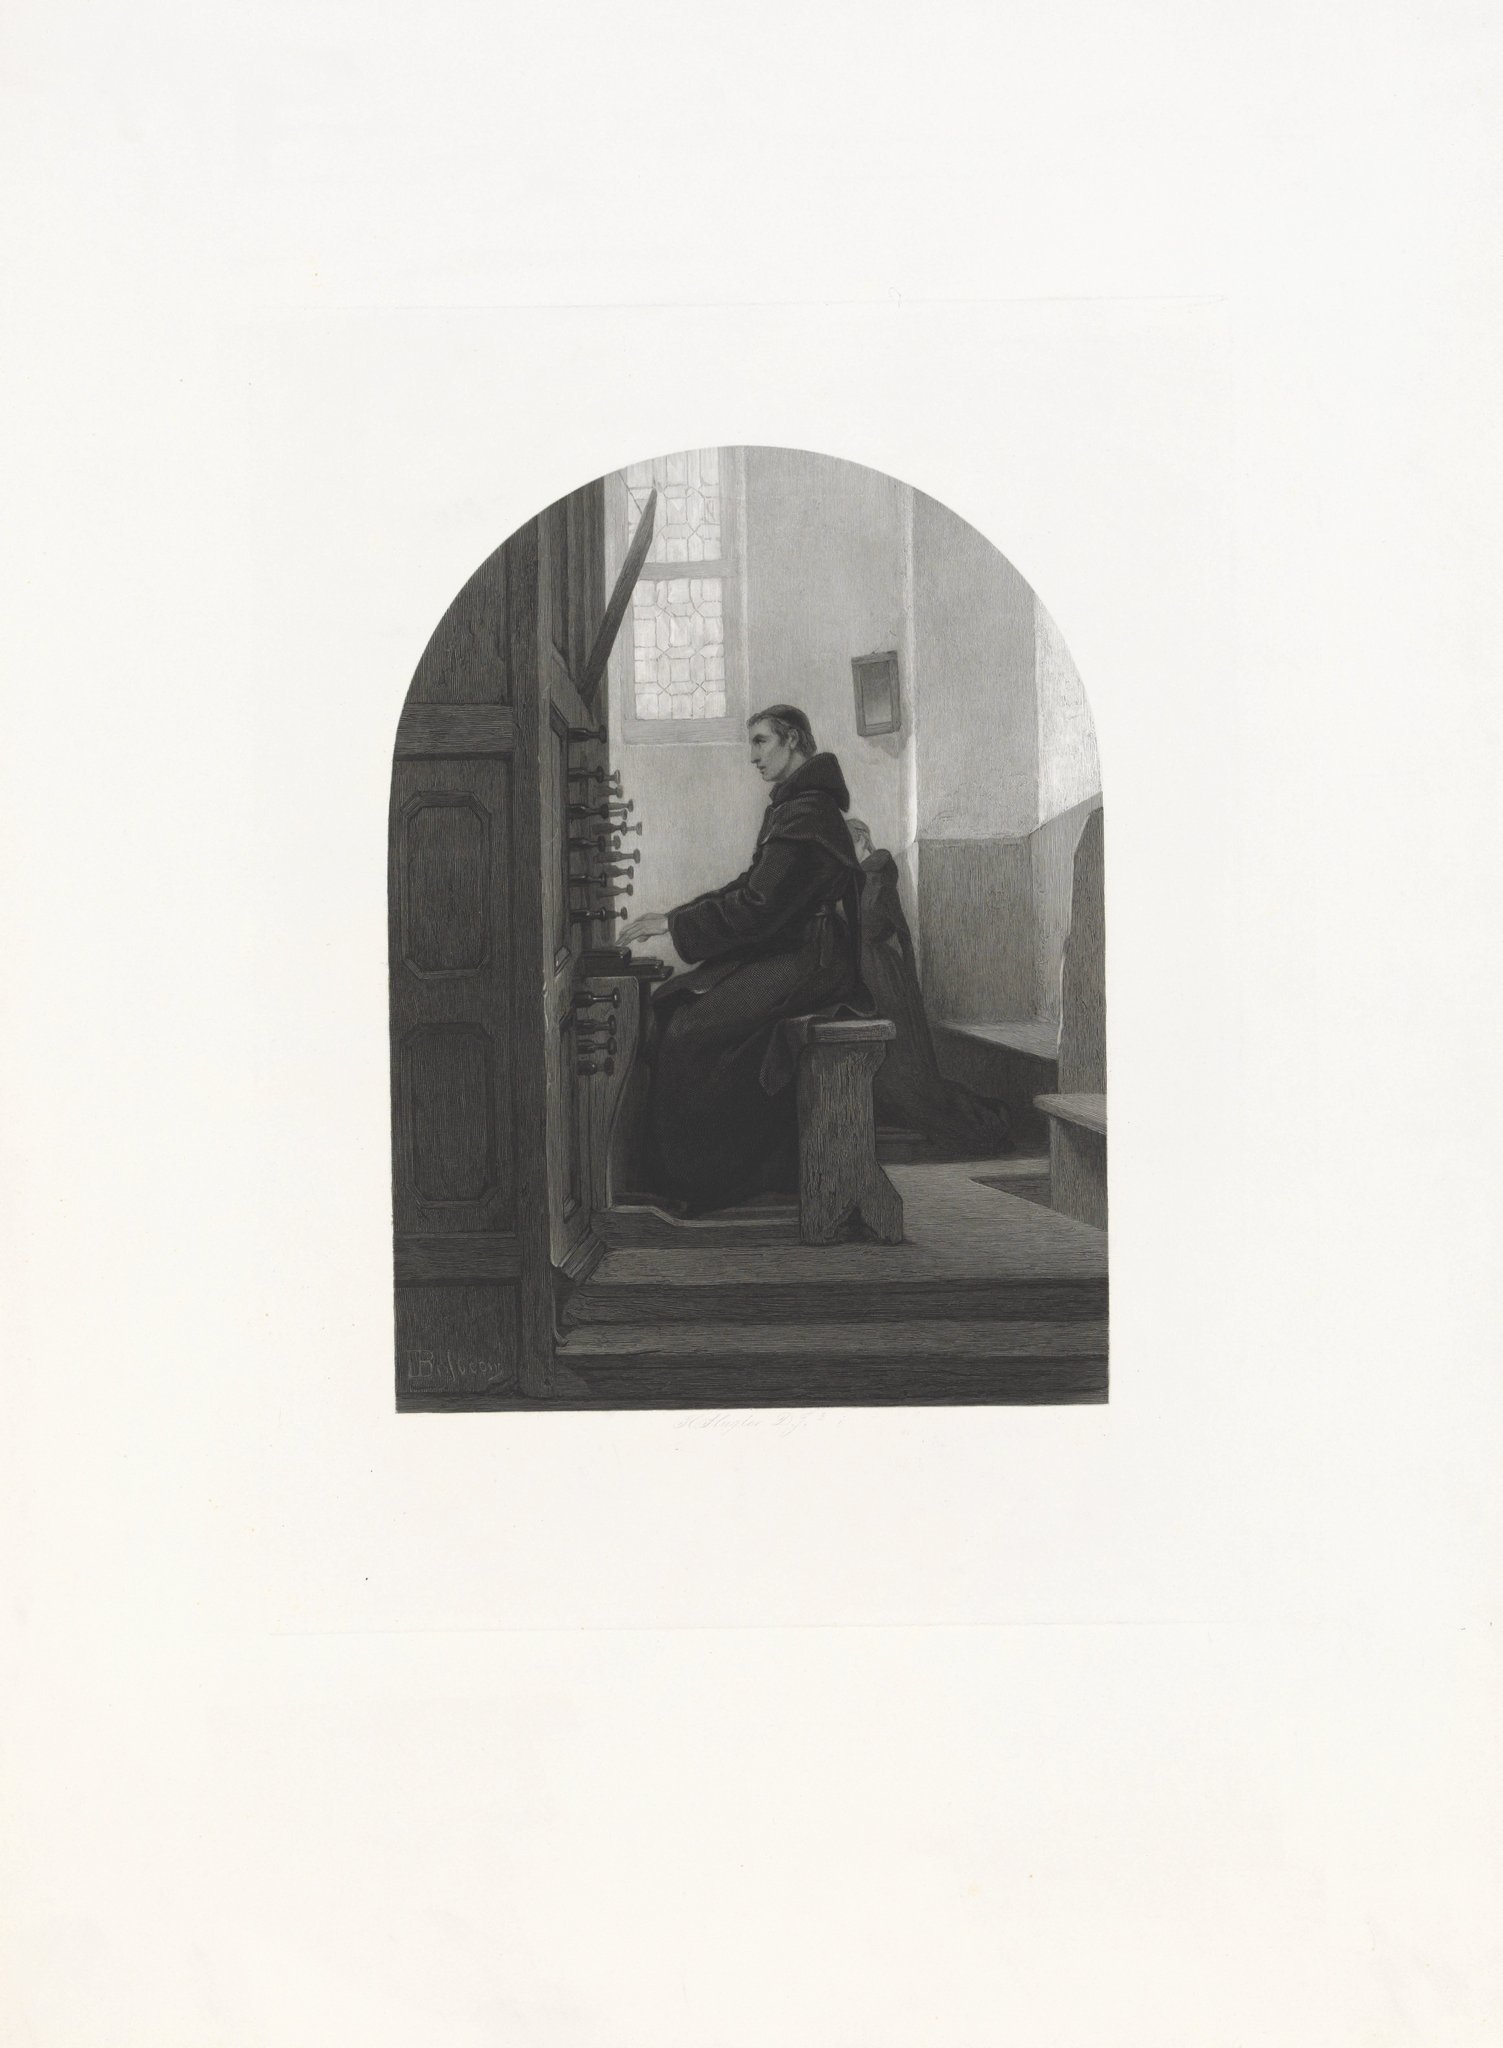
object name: print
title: Orgelspelende monnik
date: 1849-1931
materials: paper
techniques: aquatint, engraving, etching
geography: amsterdam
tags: monk(s), friar(s)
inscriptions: collector's mark: Lugt 2165, collector's mark: Lugt 2228